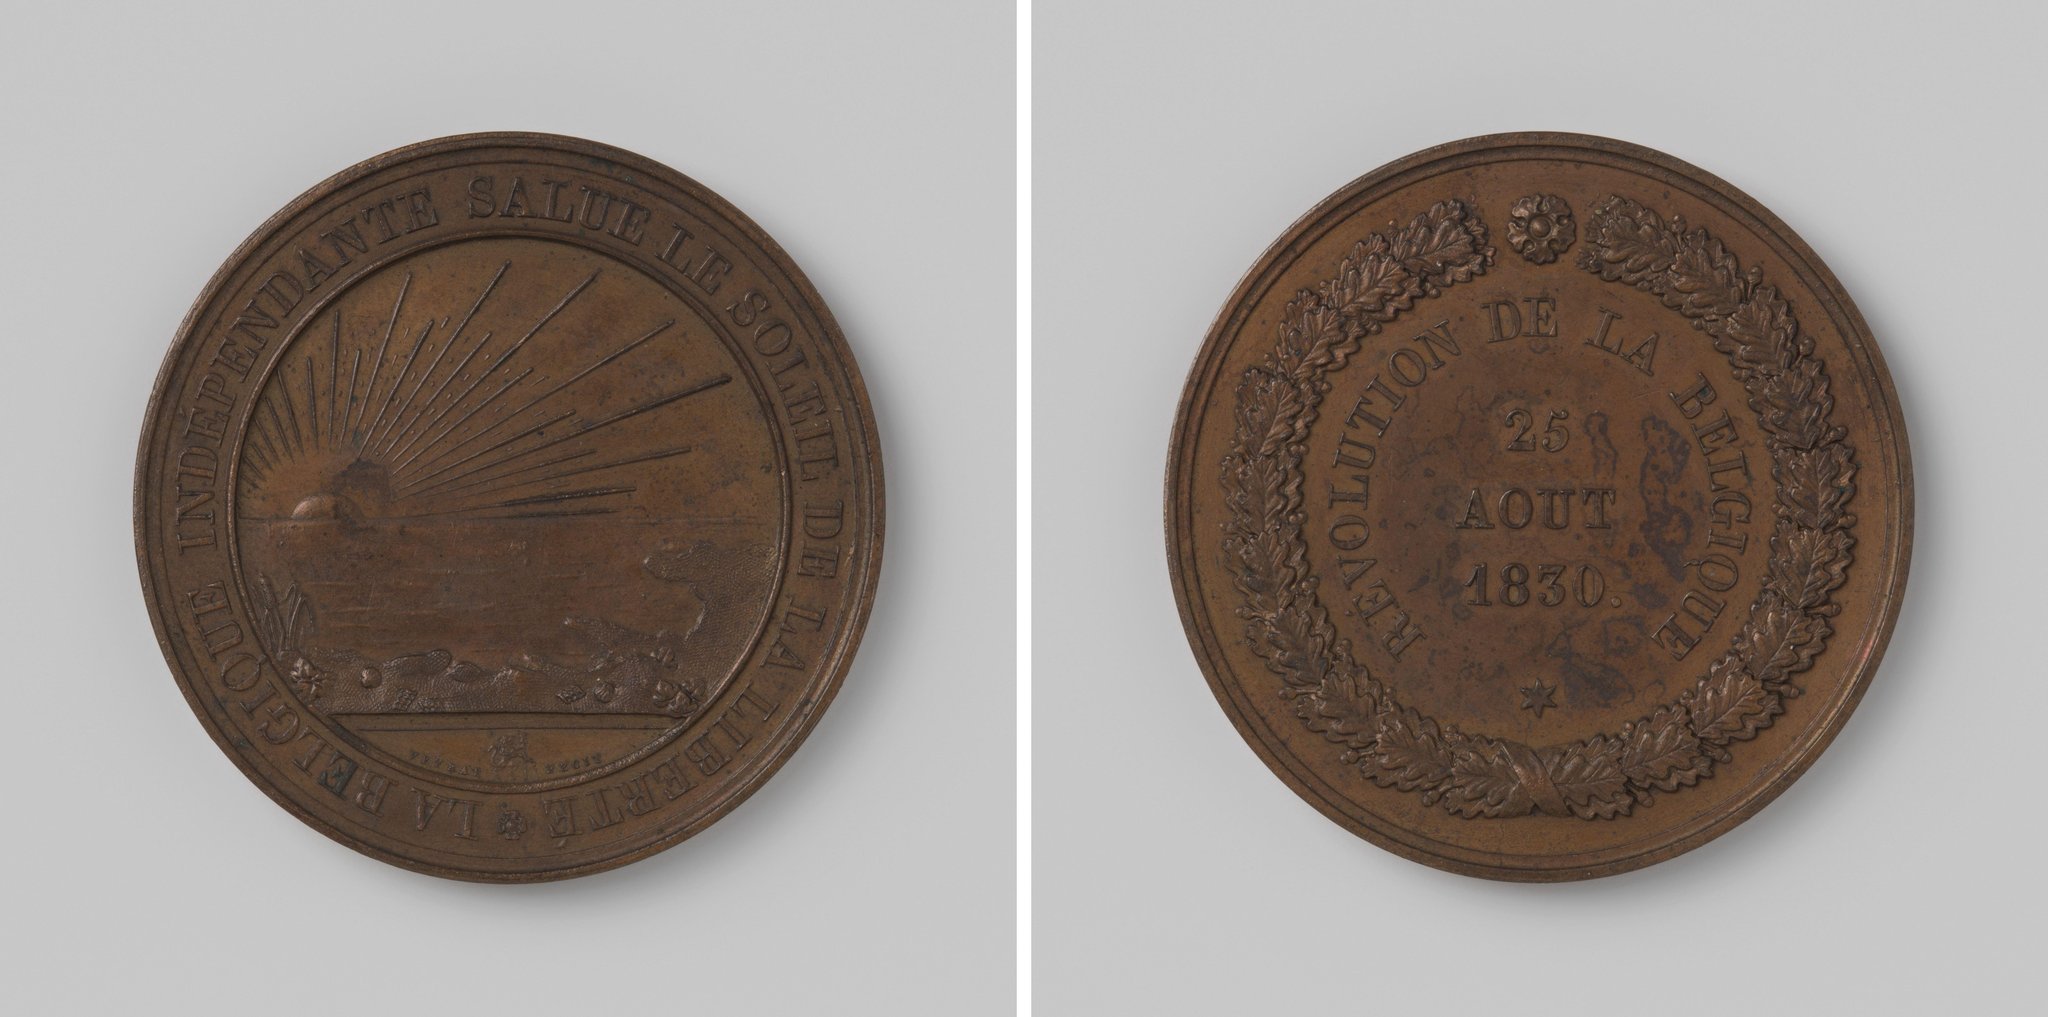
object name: history medal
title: Uitbreken van de Belgische Revolutie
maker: adrien hippolyte veyrat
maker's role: medailleur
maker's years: 1803-1883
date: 1830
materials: bronze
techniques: striking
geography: brussels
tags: william i of the netherlands, belgium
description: Bronzen penning. Voorzijde: opkomende zon beschijnt Belgische kust binnen omschrift; afsnede: signatuur onderbroken door leeuwtje met vrijheidsstaf. Keerzijde: opschrift binnen omschrift en eikenkrans.